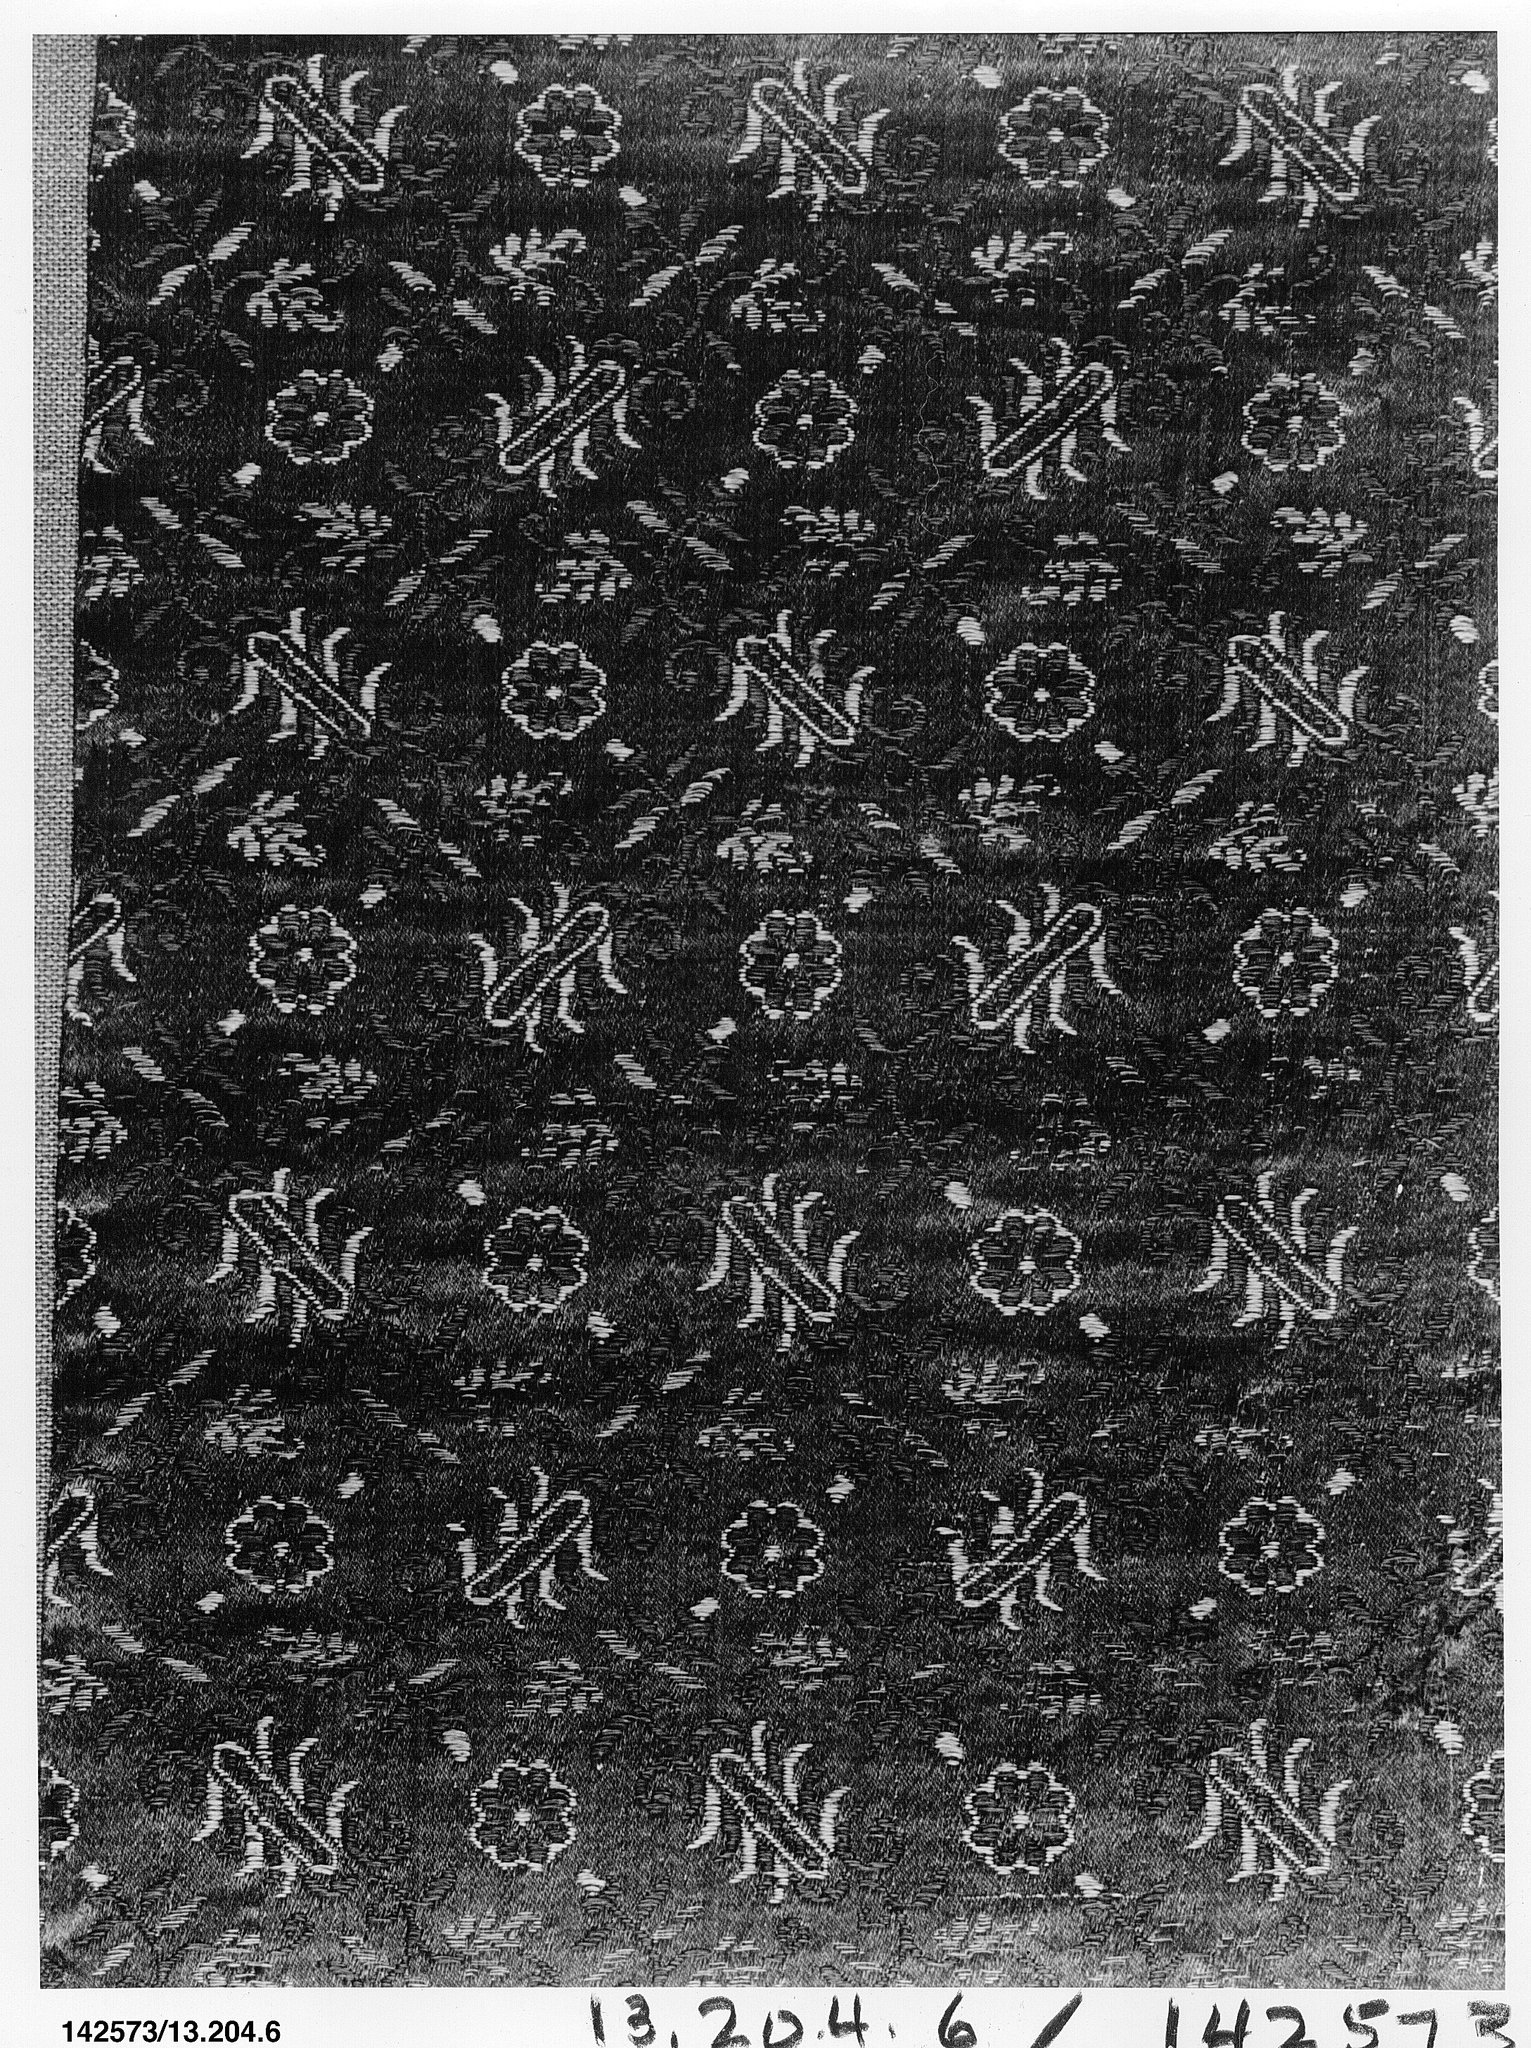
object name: piece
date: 1501-1600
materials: silk